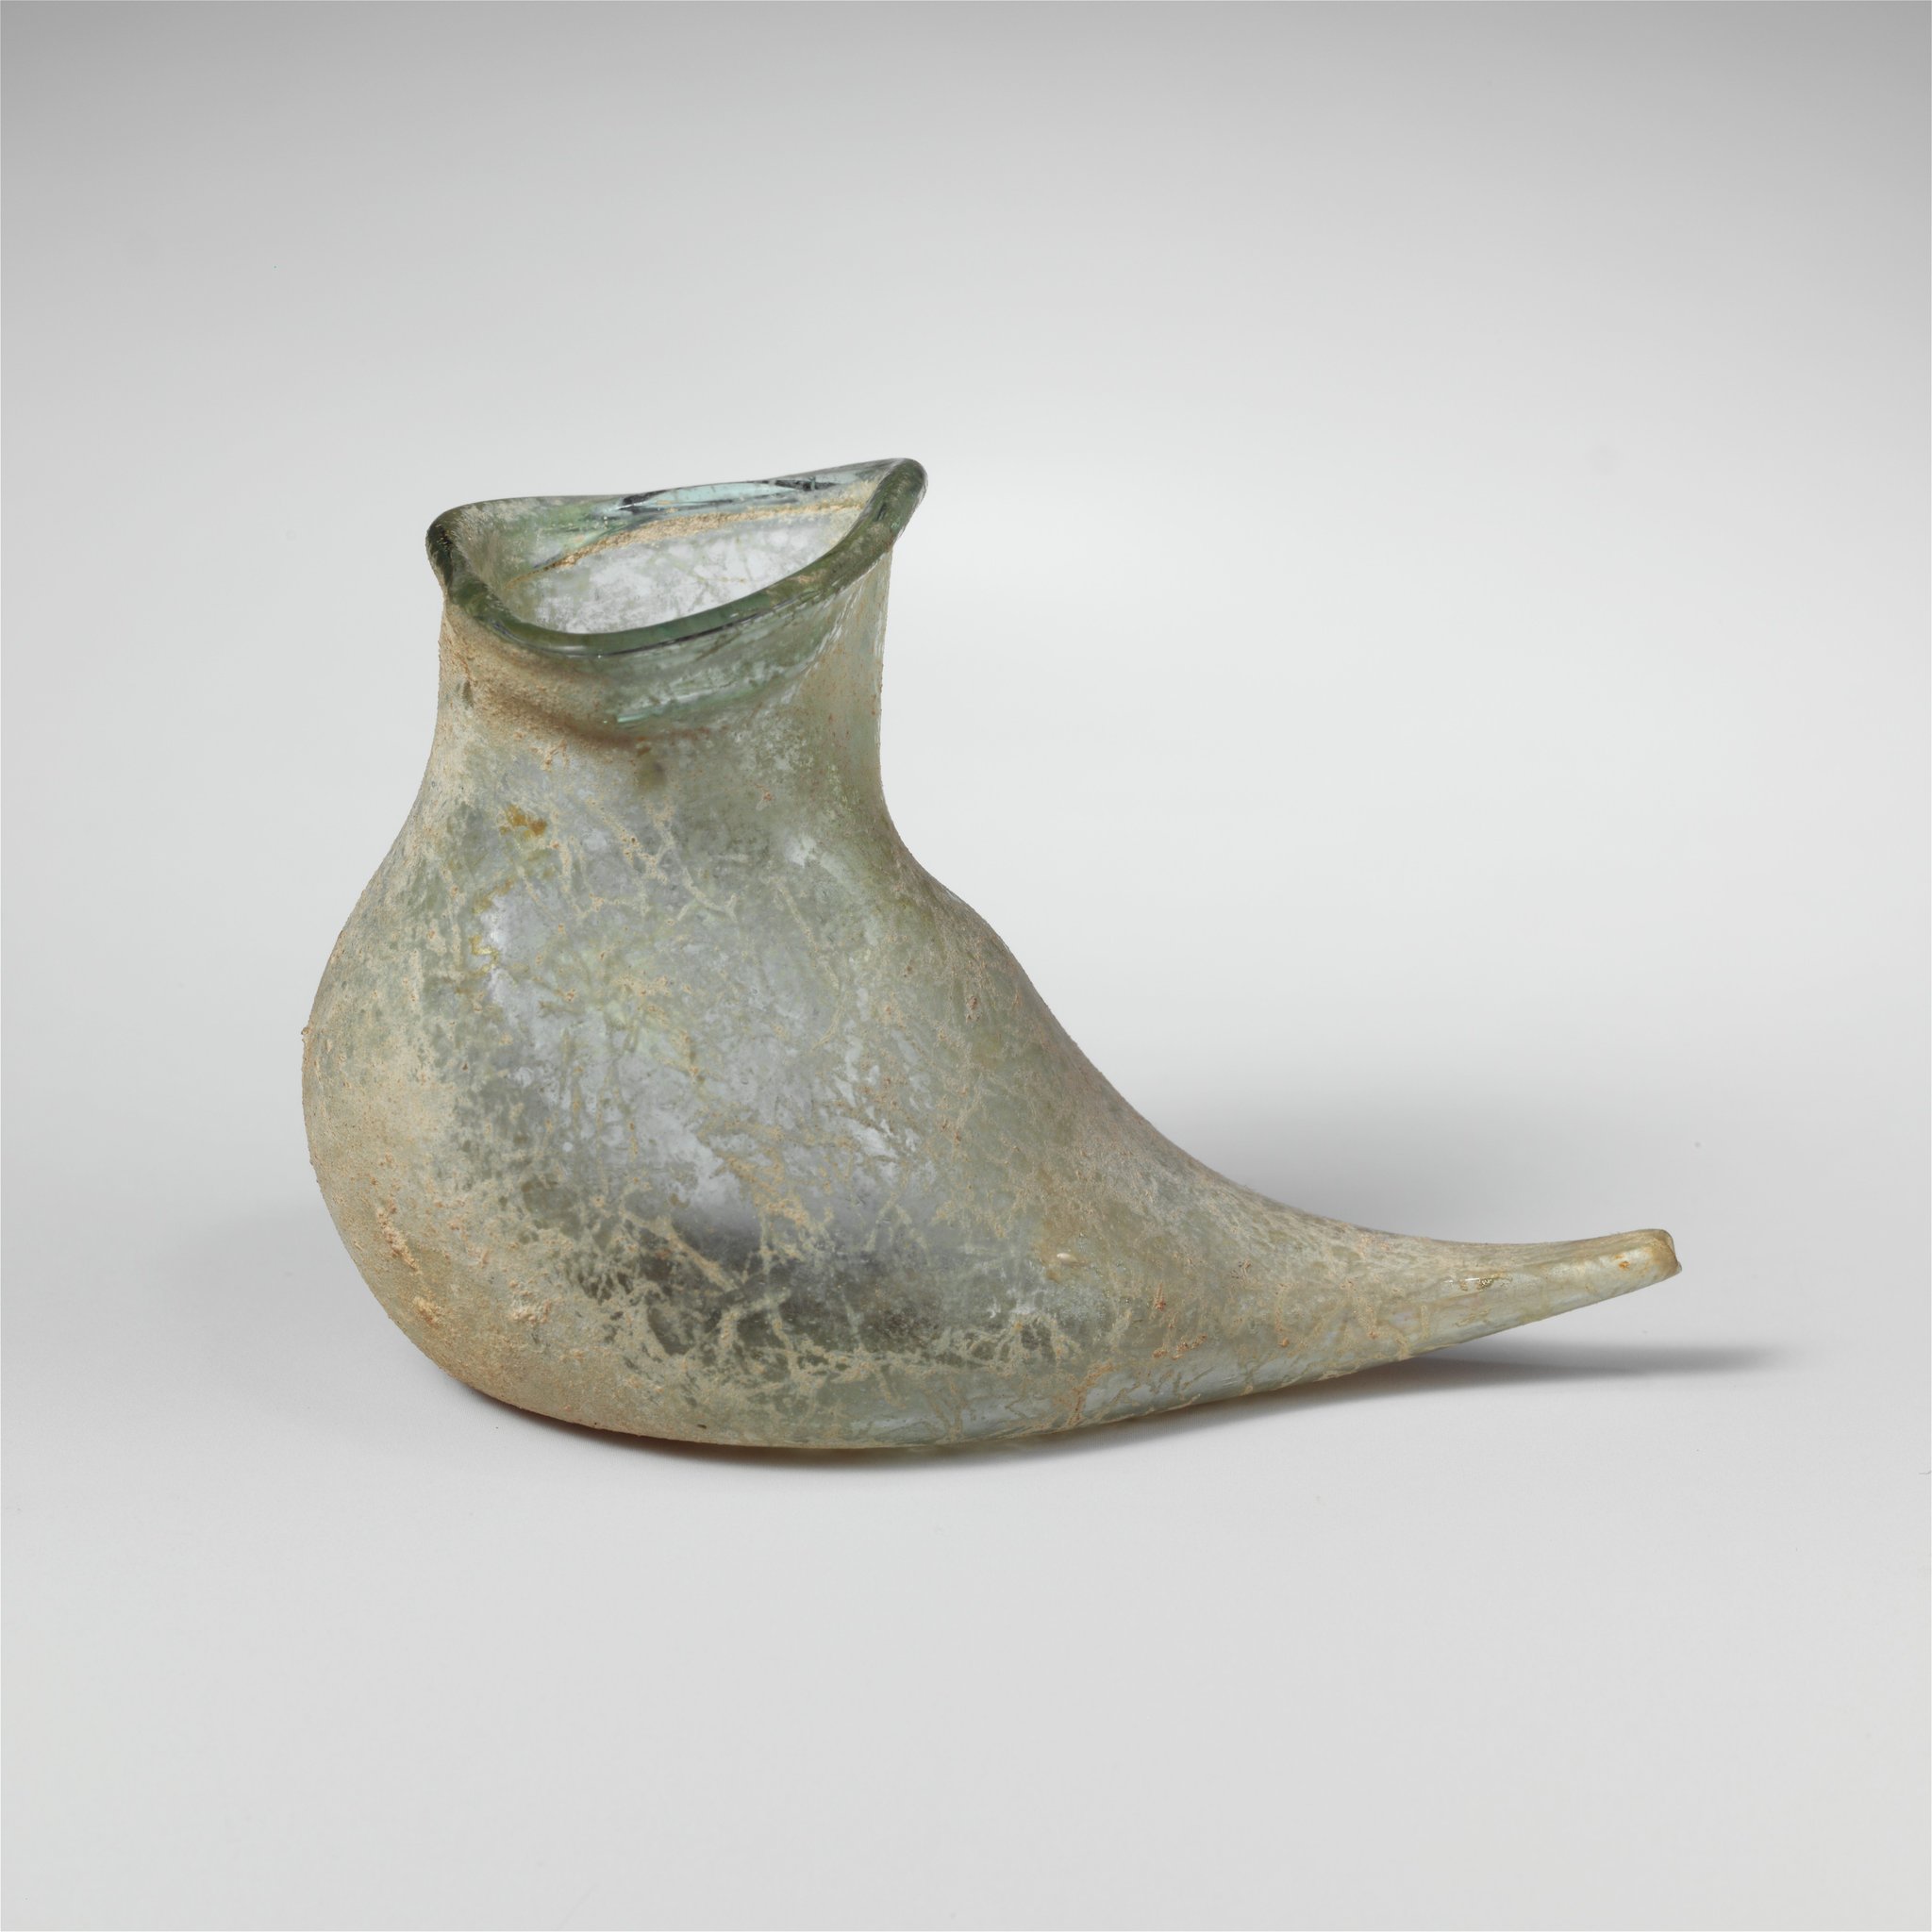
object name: pourer flask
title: Glass pourer flask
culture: roman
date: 1-200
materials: glass